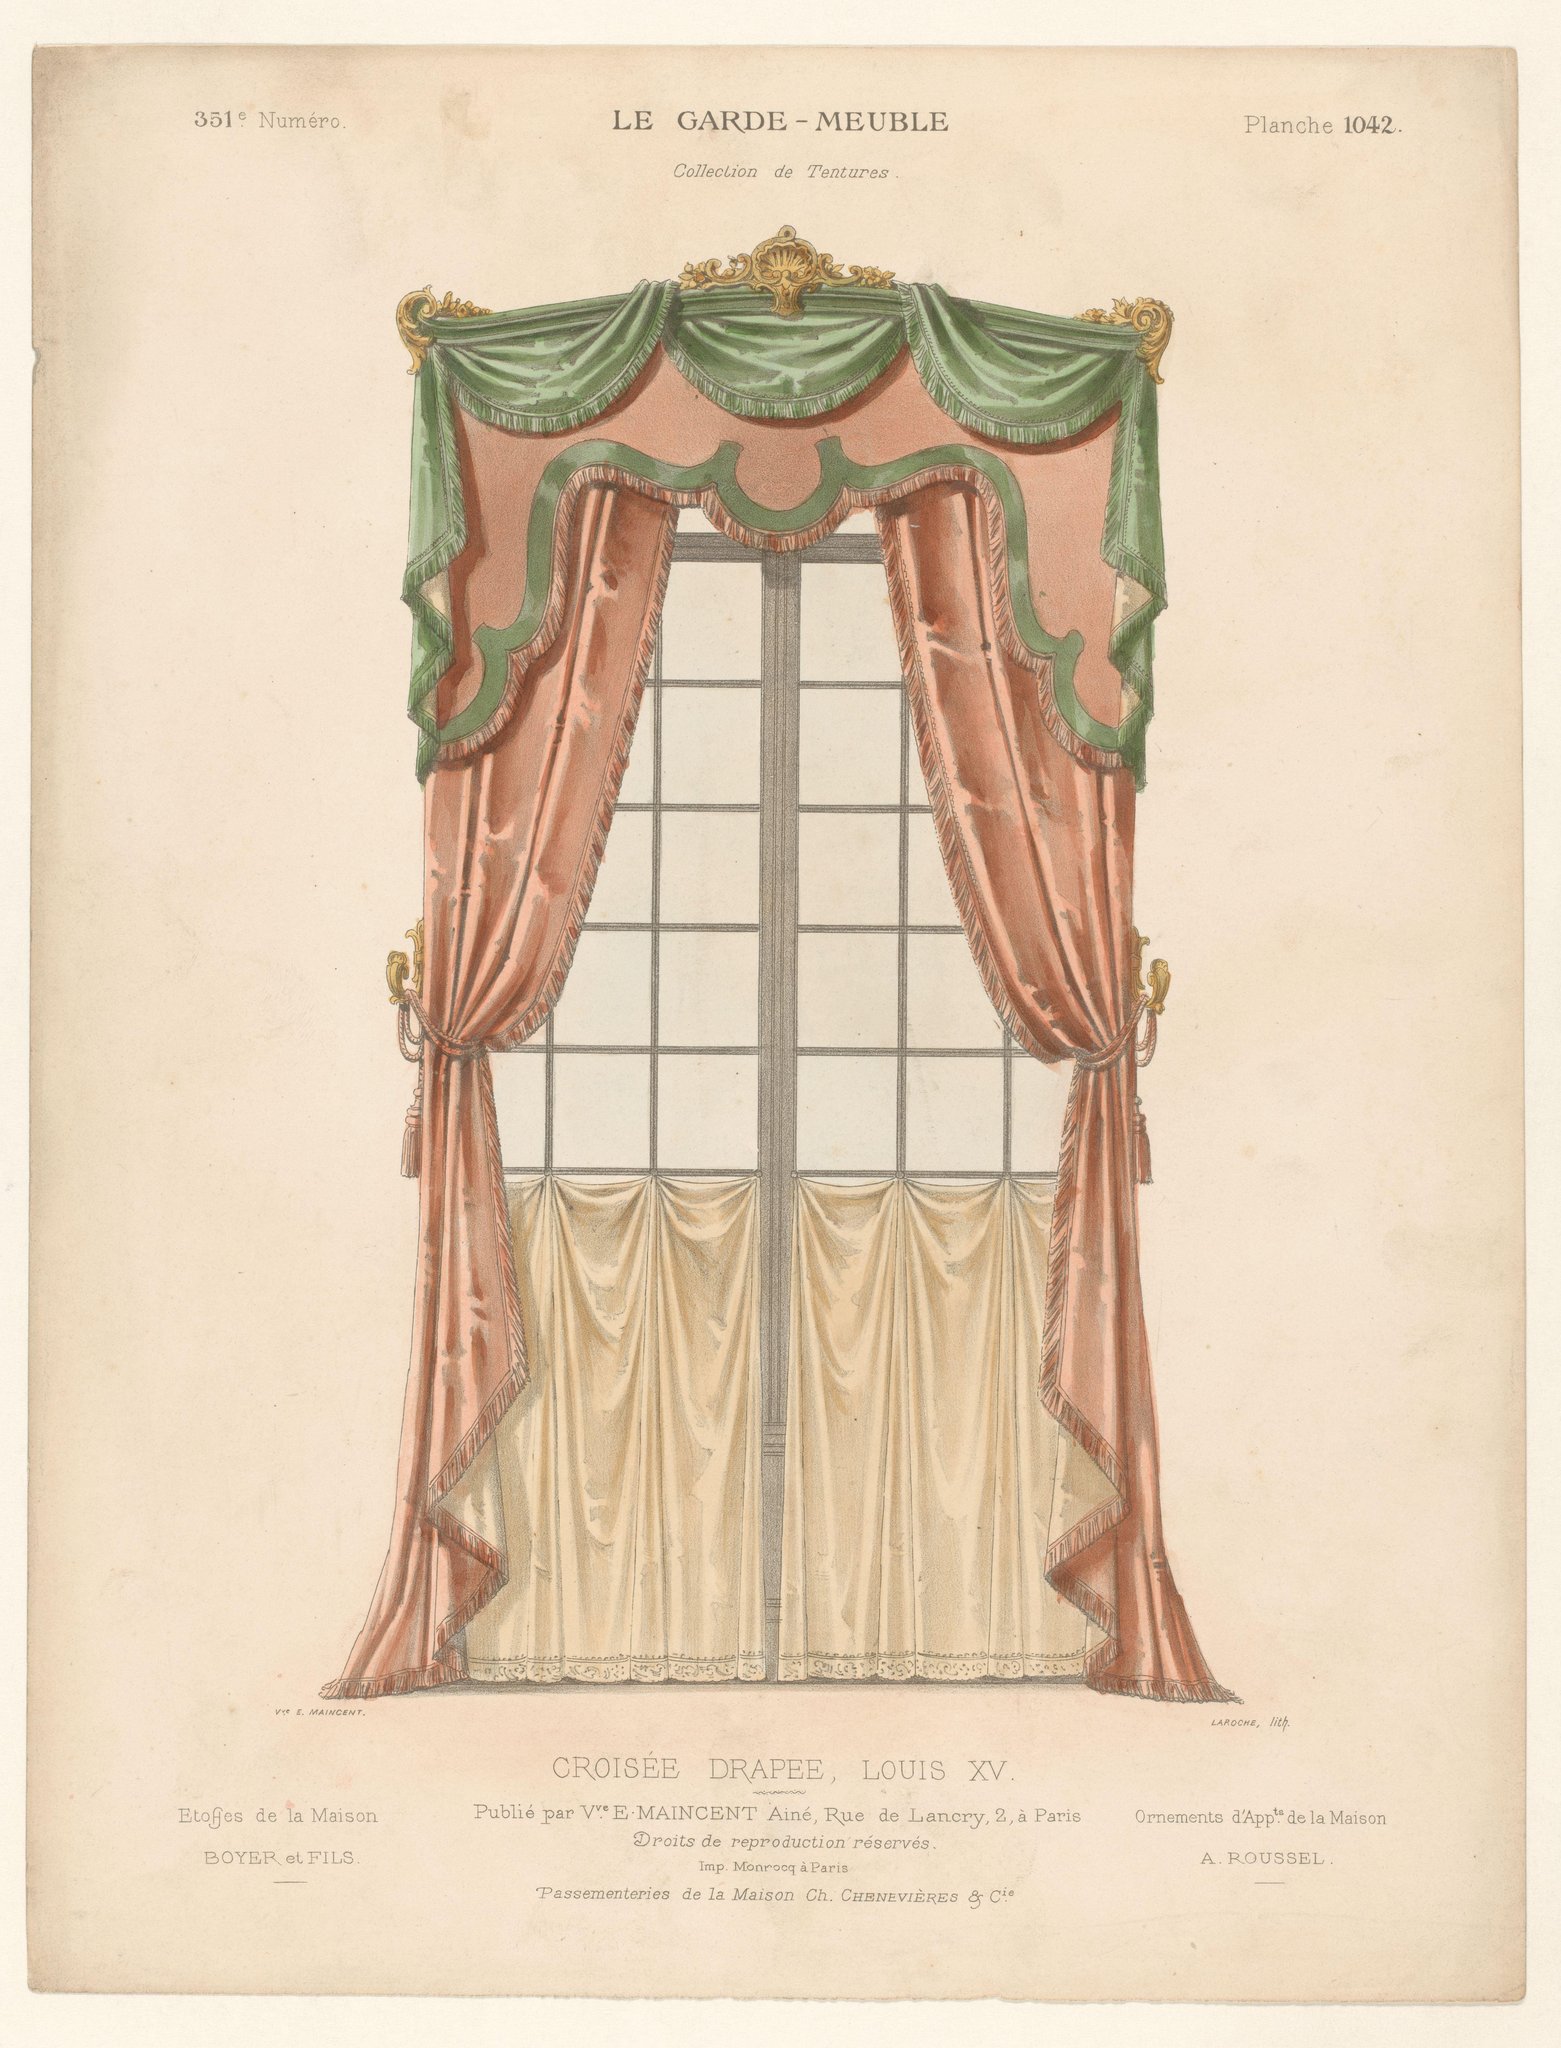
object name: print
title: Croisée drapée, Louis XV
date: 1895-1910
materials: paper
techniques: hand coloring, lithograph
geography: paris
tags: window, hangings and drapery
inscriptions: : ‘Droits de reproduction réservés.’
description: Kruisvenster met gedrapeerde gordijnen in de Lodewijk XV-stijl. Prent uit 351e Livraison.